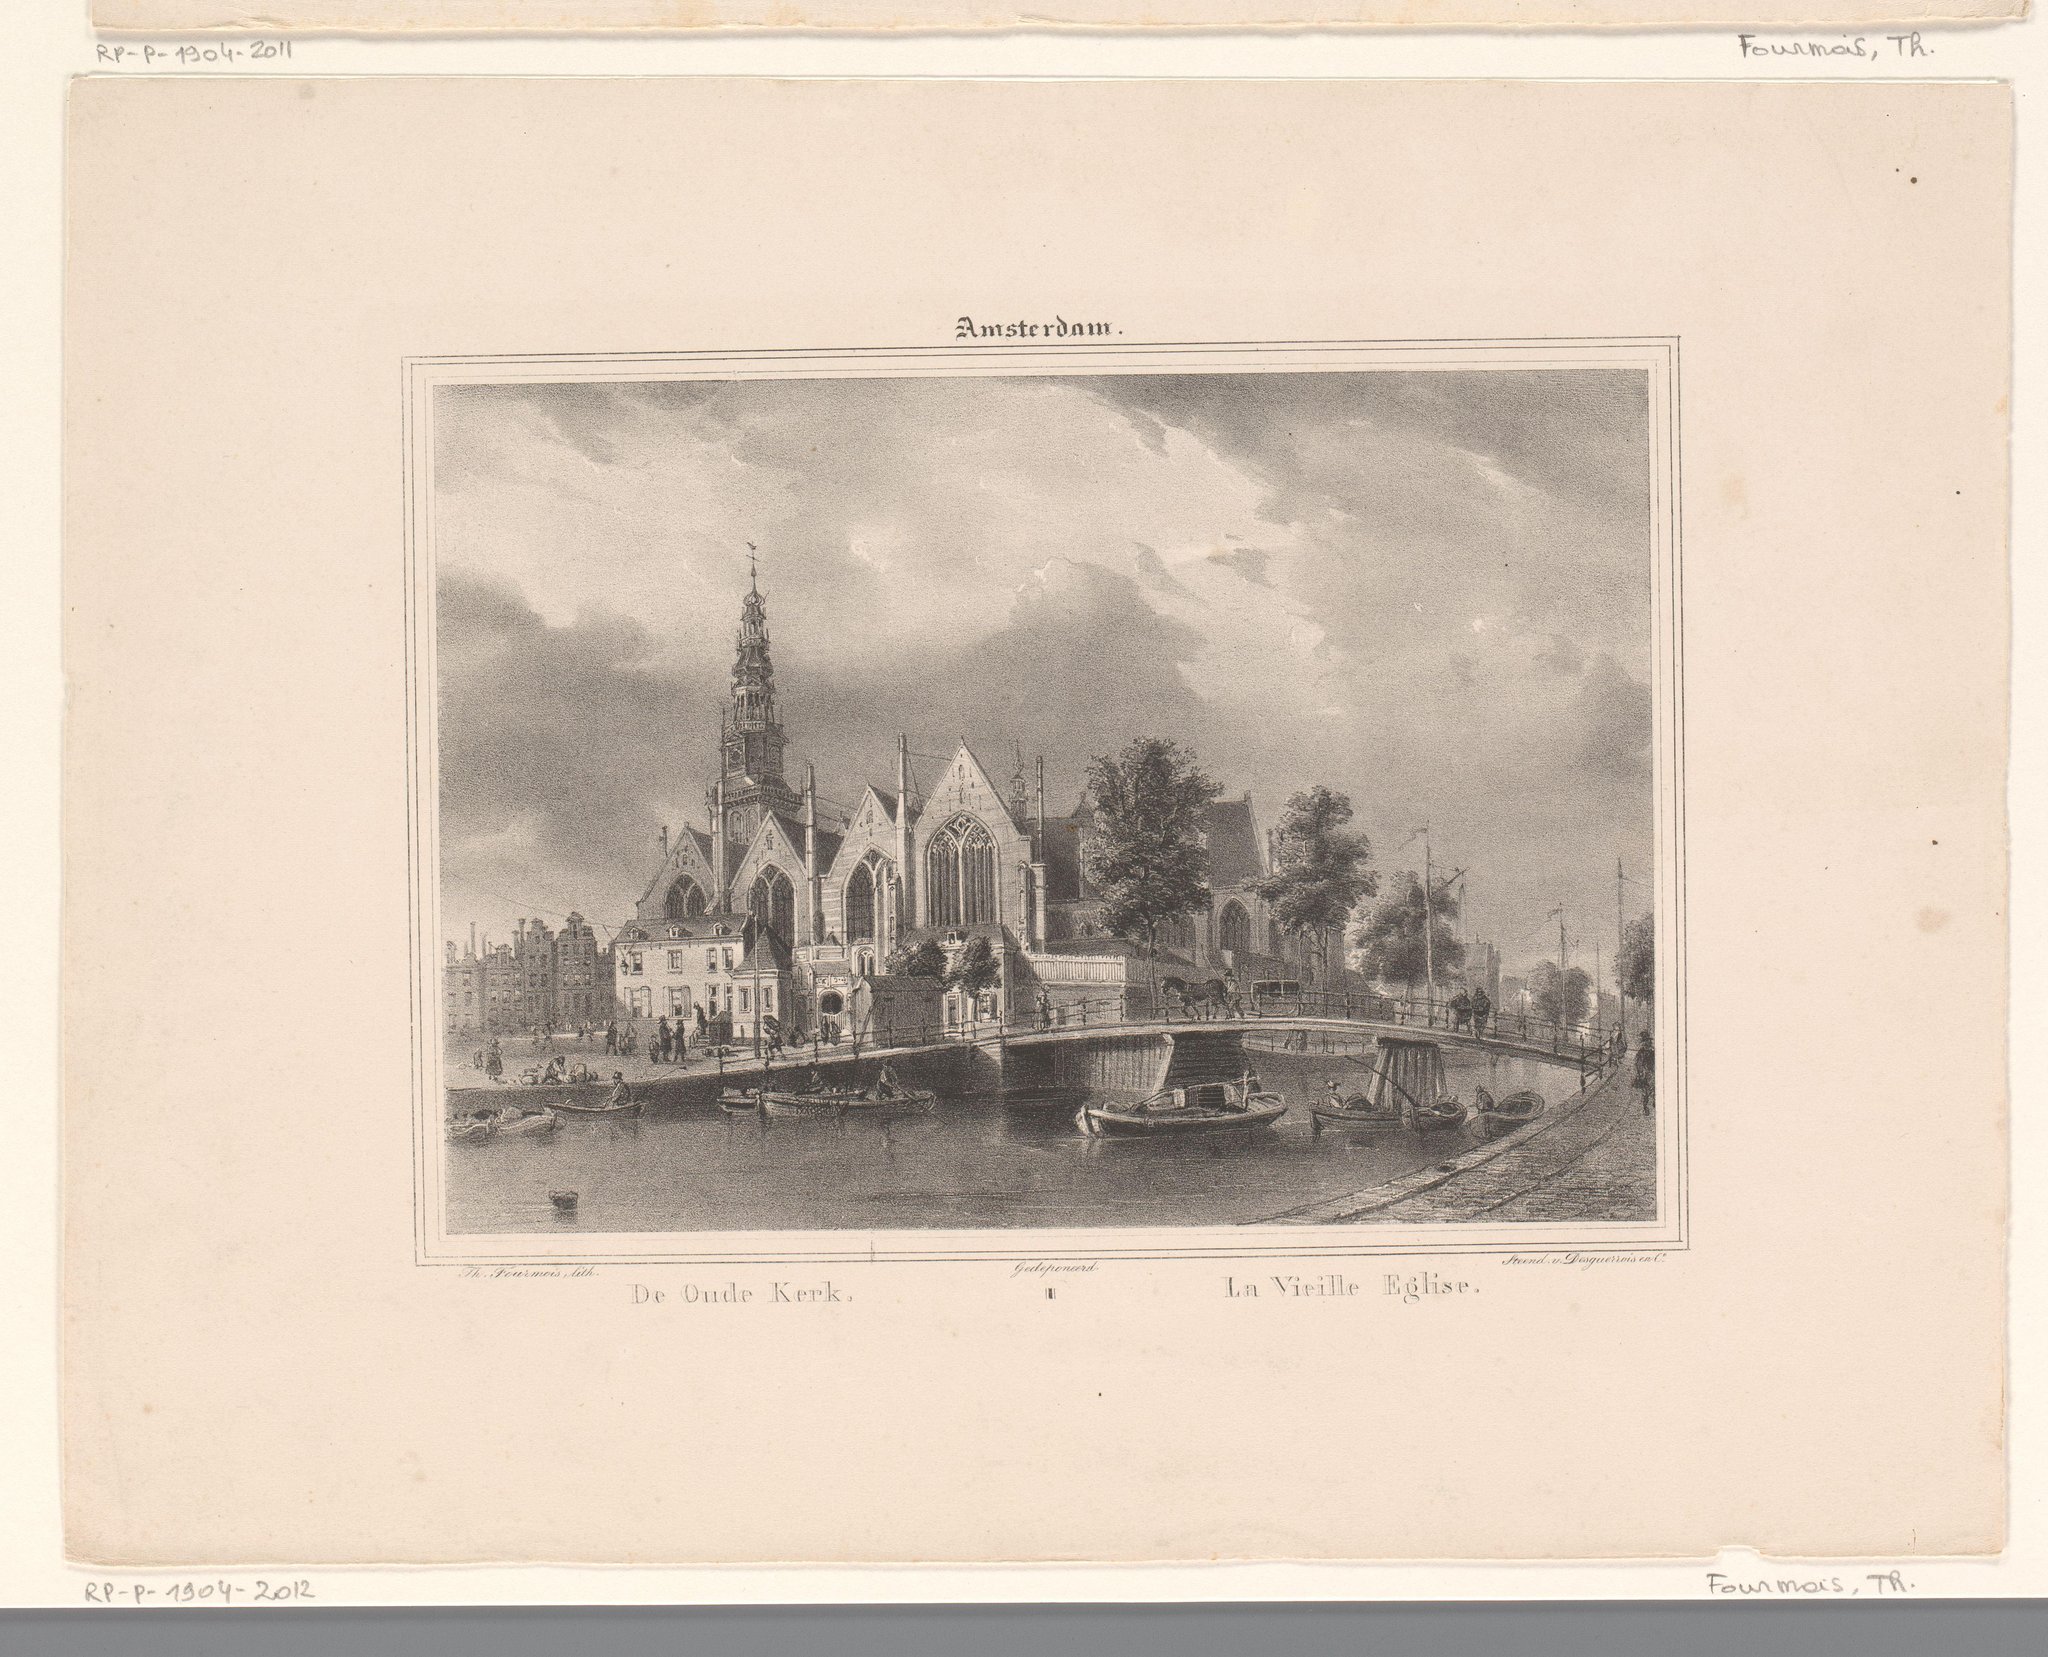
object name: print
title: Amsterdam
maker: théodore fourmois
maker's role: print maker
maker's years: 1814-1871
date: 1830-1840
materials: paper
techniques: lithograph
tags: church (exterior), canals, waters (in city), boat propelled by man or animal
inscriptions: : ‘Gedeponeerd’, collector's mark: Lugt 2228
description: Prent behoort mogelijk tot een serie met gezichten op Amsterdam, Rotterdam, Haarlem, Den Haag en Huis te Brederode. Desguerrois heeft hier midden jaren dertig opdracht voor gegeven aan onder meer Lauters, Fourmois en Clerman.